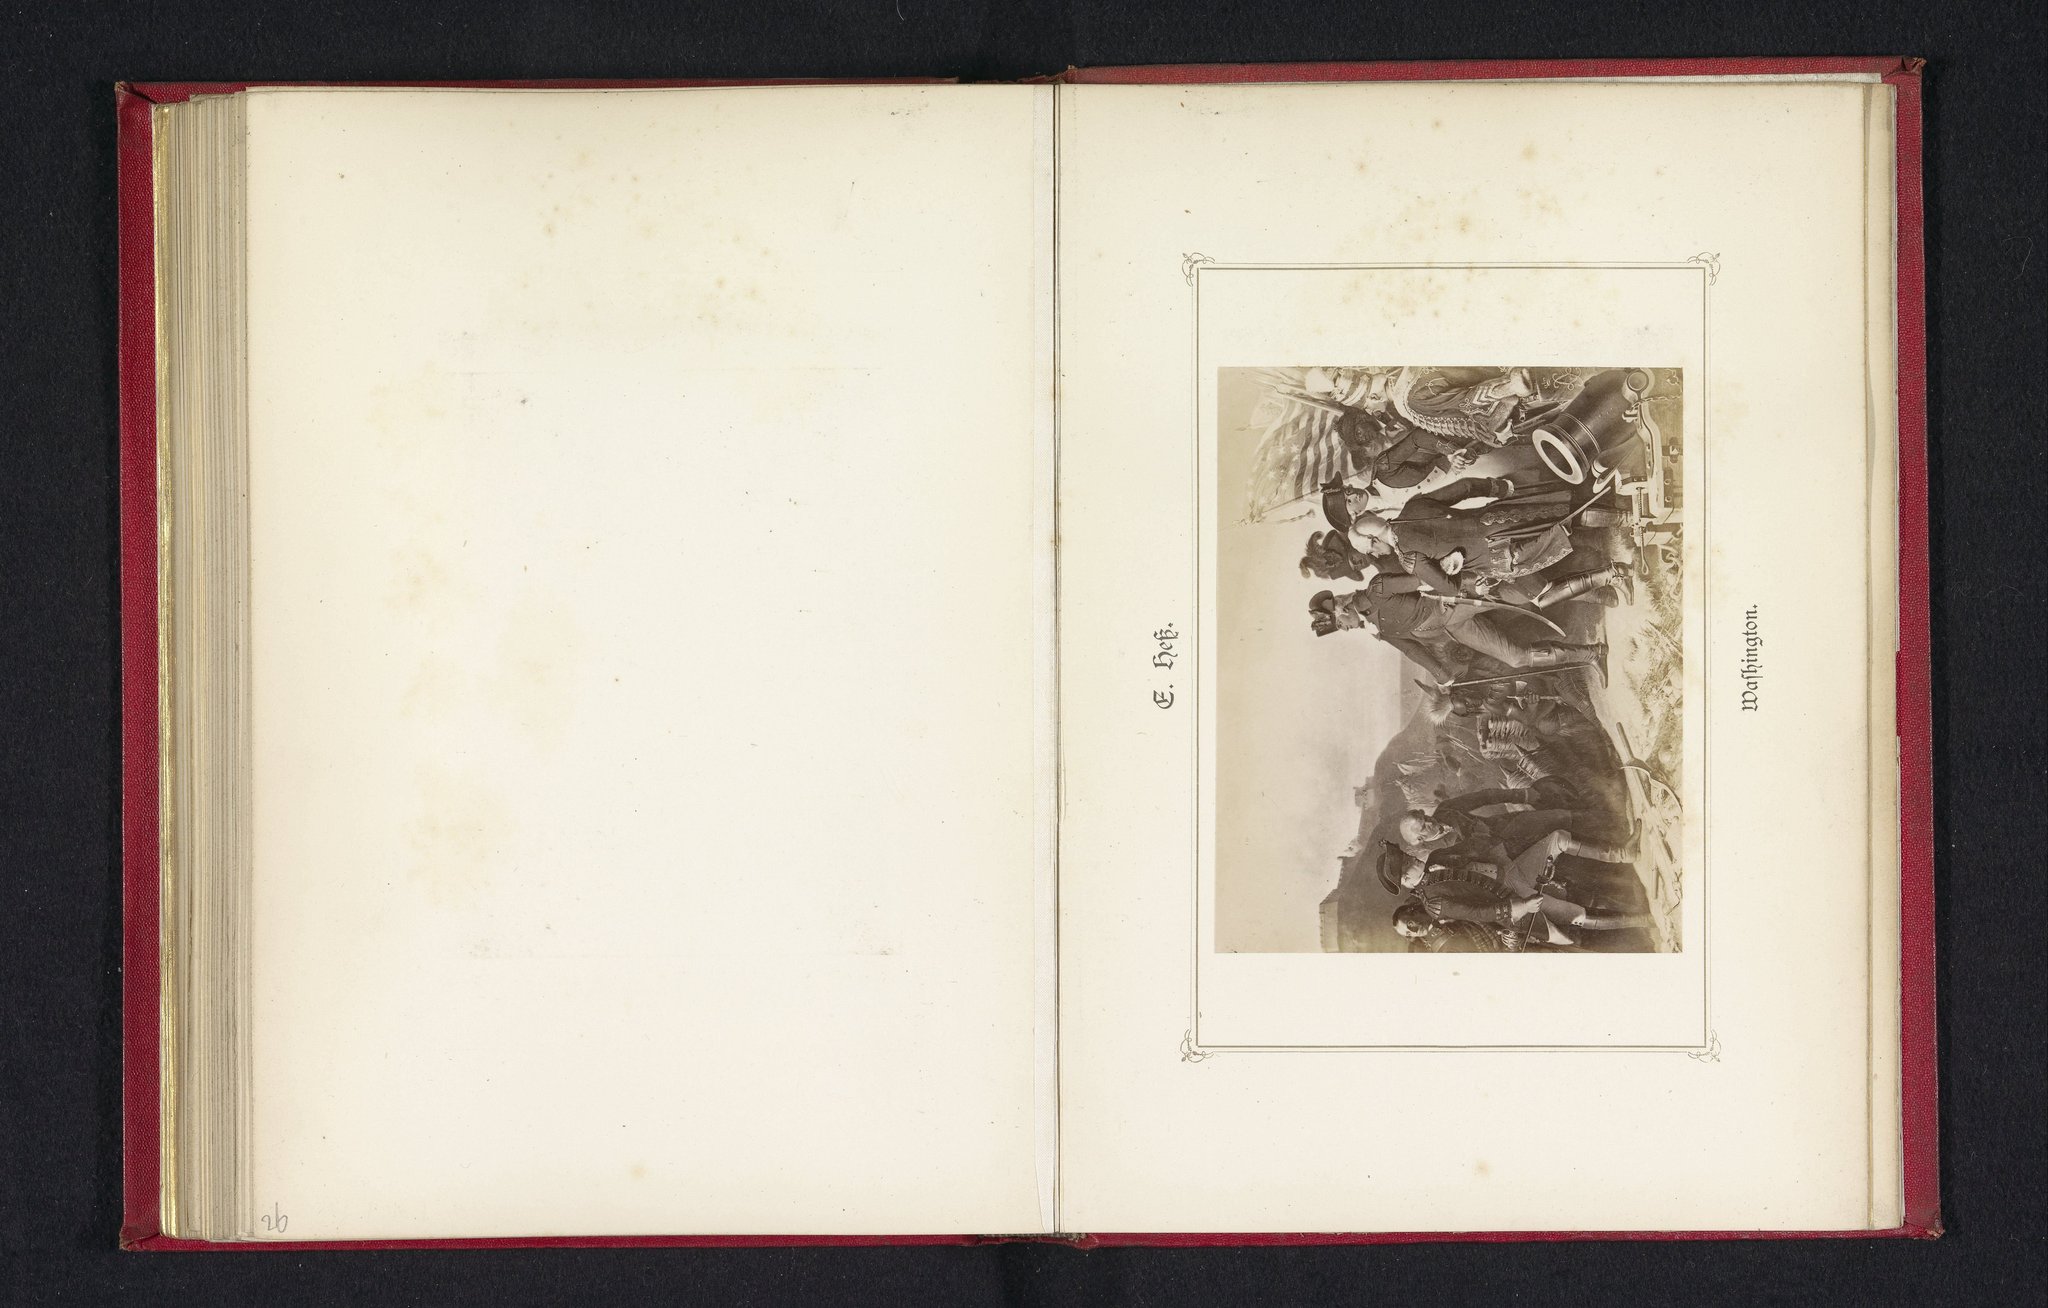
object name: photograph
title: Fotoreproductie van een schilderij, voorstellende de Britse troepen geven zich over aan George Washington na de Slag bij Yorktown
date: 1875-1880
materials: photographic support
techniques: albumen print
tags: the defeated before the victor, surrender ~ war